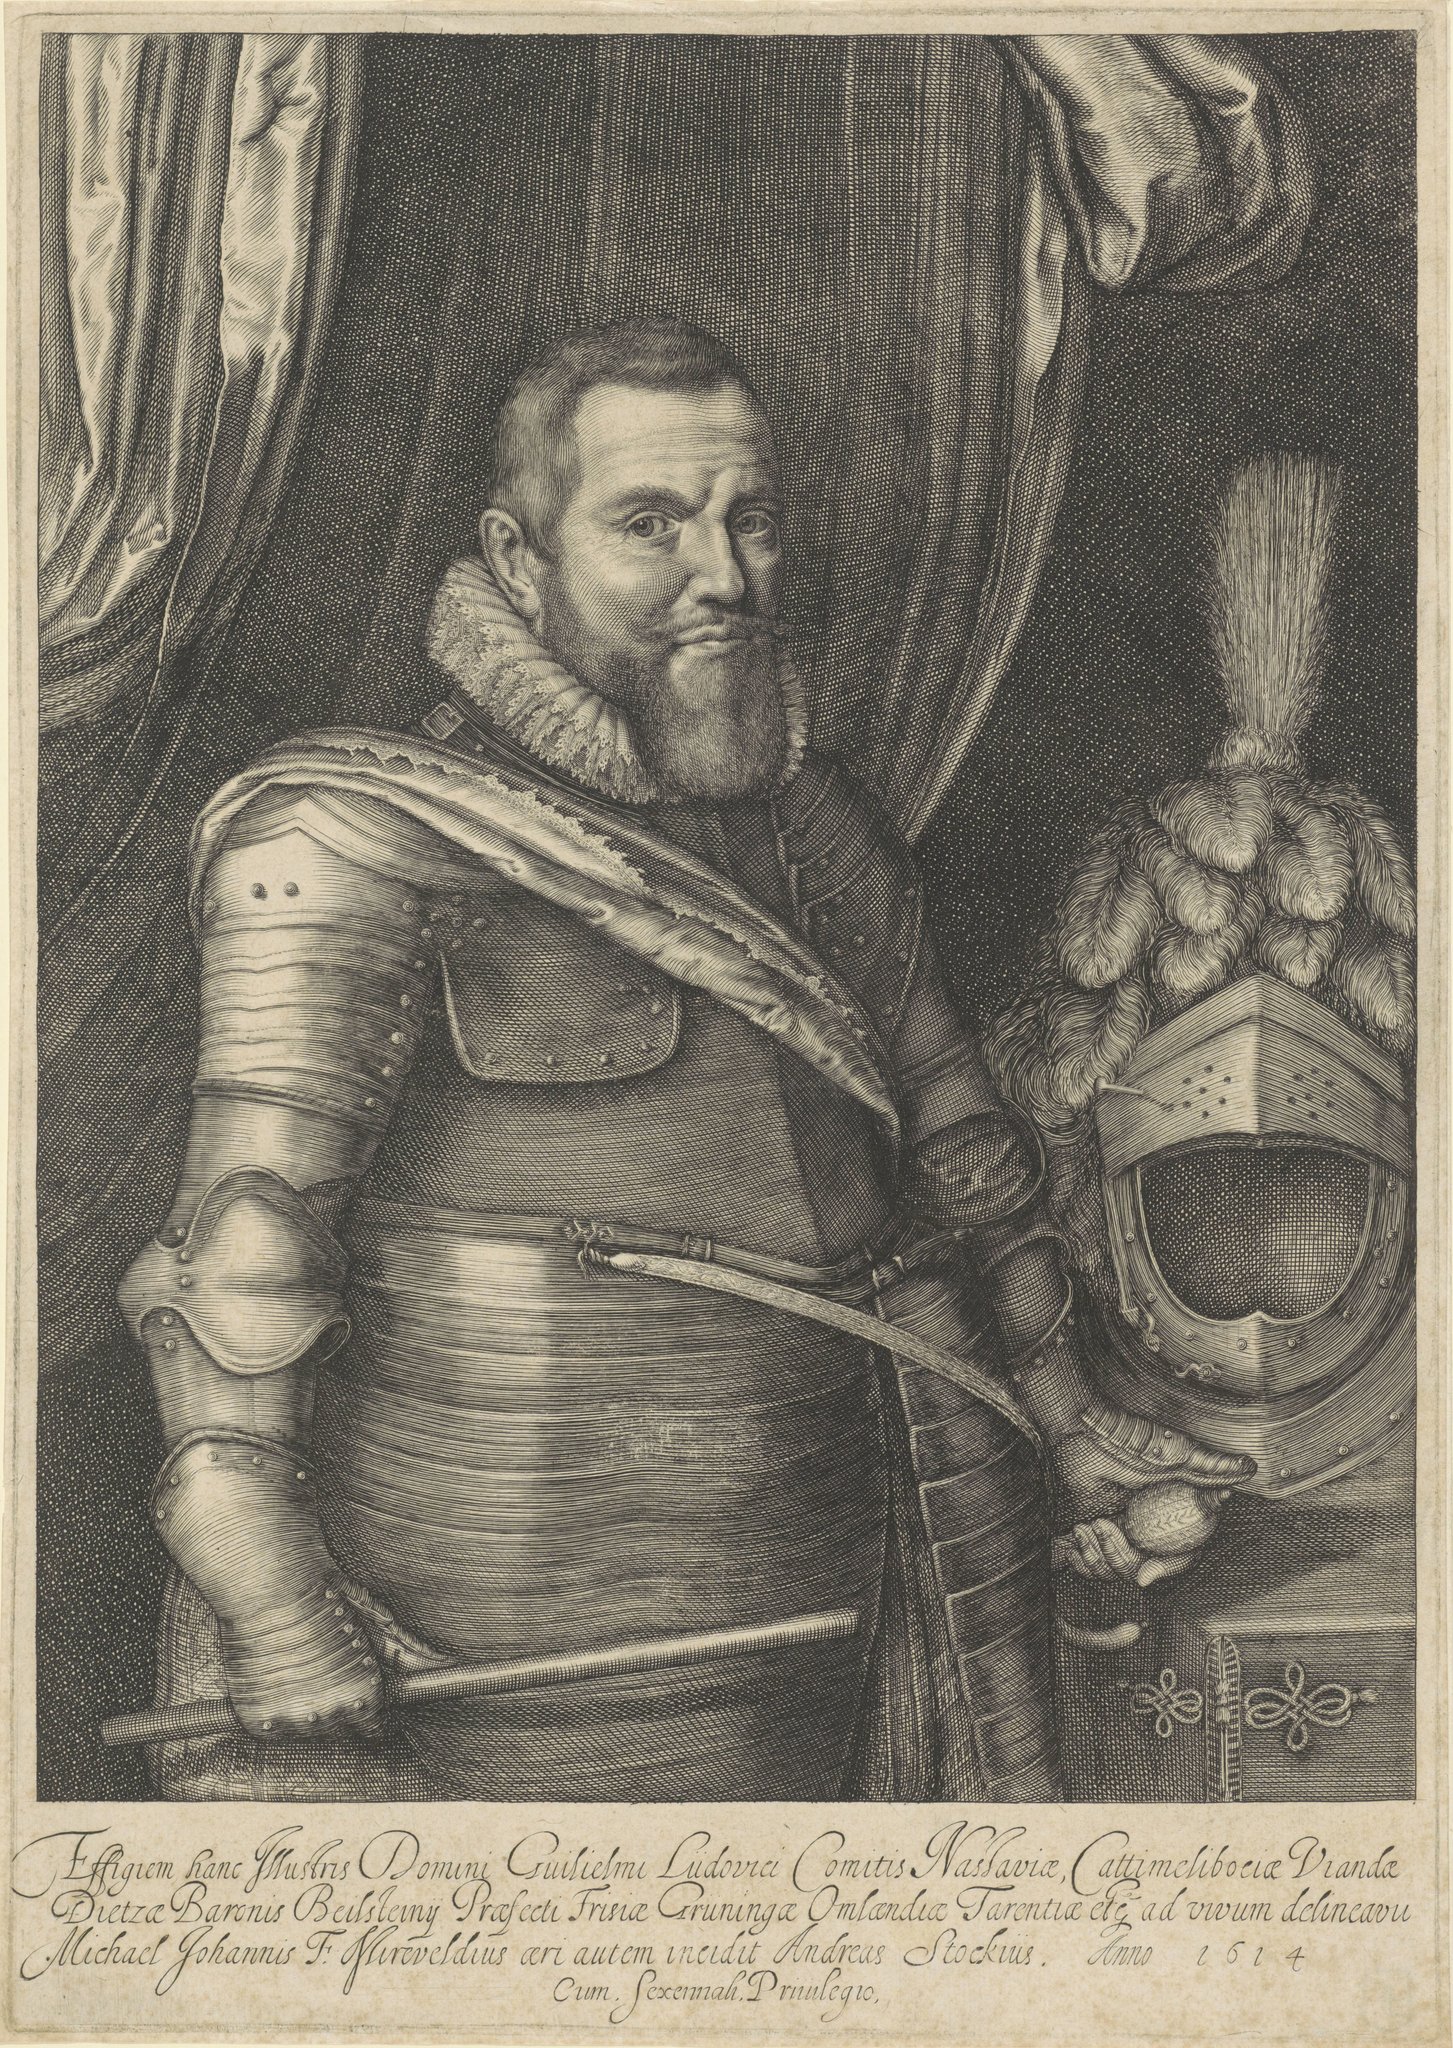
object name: print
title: Portret van Willem Lodewijk, graaf van Nassau-Dillenburg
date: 1614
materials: paper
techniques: engraving, etching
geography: the hague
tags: willem lodewijk graaf van nassau-dillenburg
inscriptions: collector's mark: Lugt 963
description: De hier vermelde titel verwijst naar de hoogst verkregen titel van de geportretteerde, niet per se naar de titel die de geportretteerde op deze voorstelling draagt.